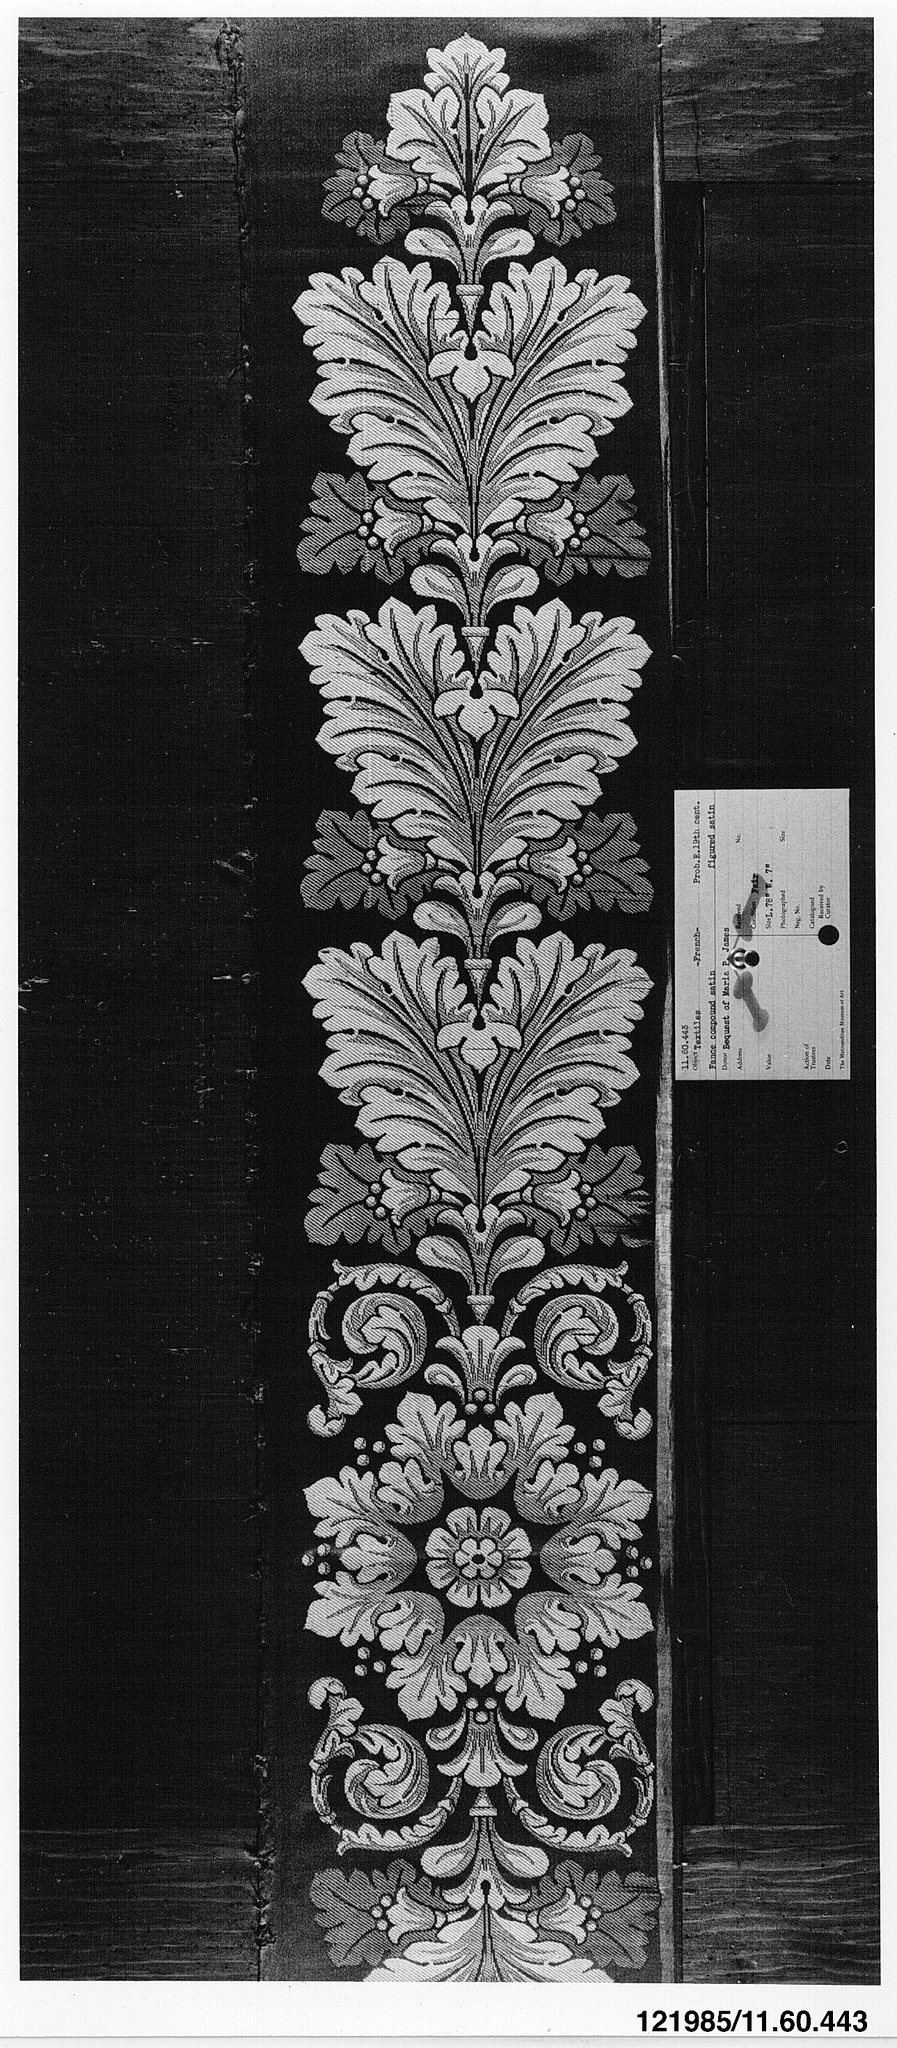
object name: piece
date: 1801-1833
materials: silk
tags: flowers,leaves